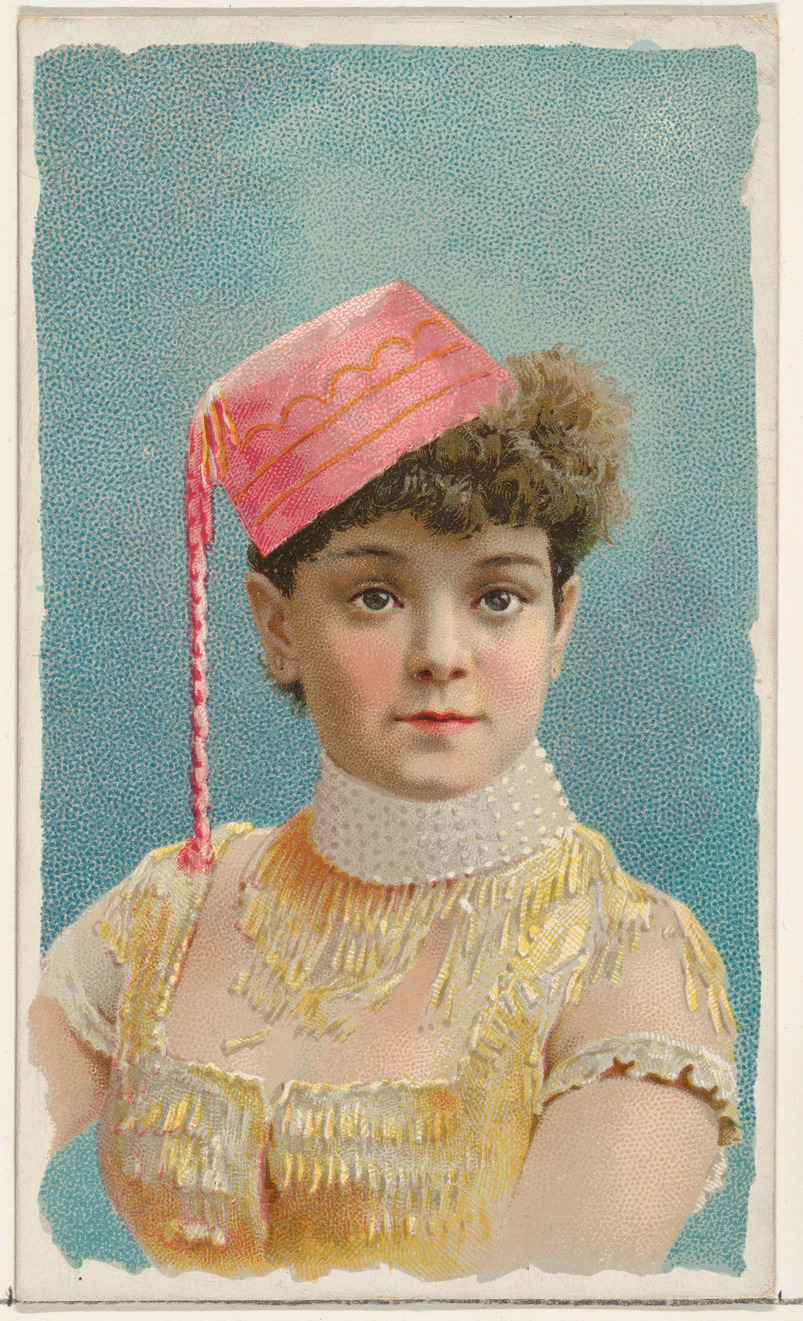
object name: print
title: Actress wearing pink fez, from Stars of the Stage, First Series (N129) issued by W. Duke, Sons & Co. to promote Honest Long Cut Tobacco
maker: w. duke, sons & co.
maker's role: publisher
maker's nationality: american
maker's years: 1870-1920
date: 1890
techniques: color lithograph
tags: portraits,women,actresses